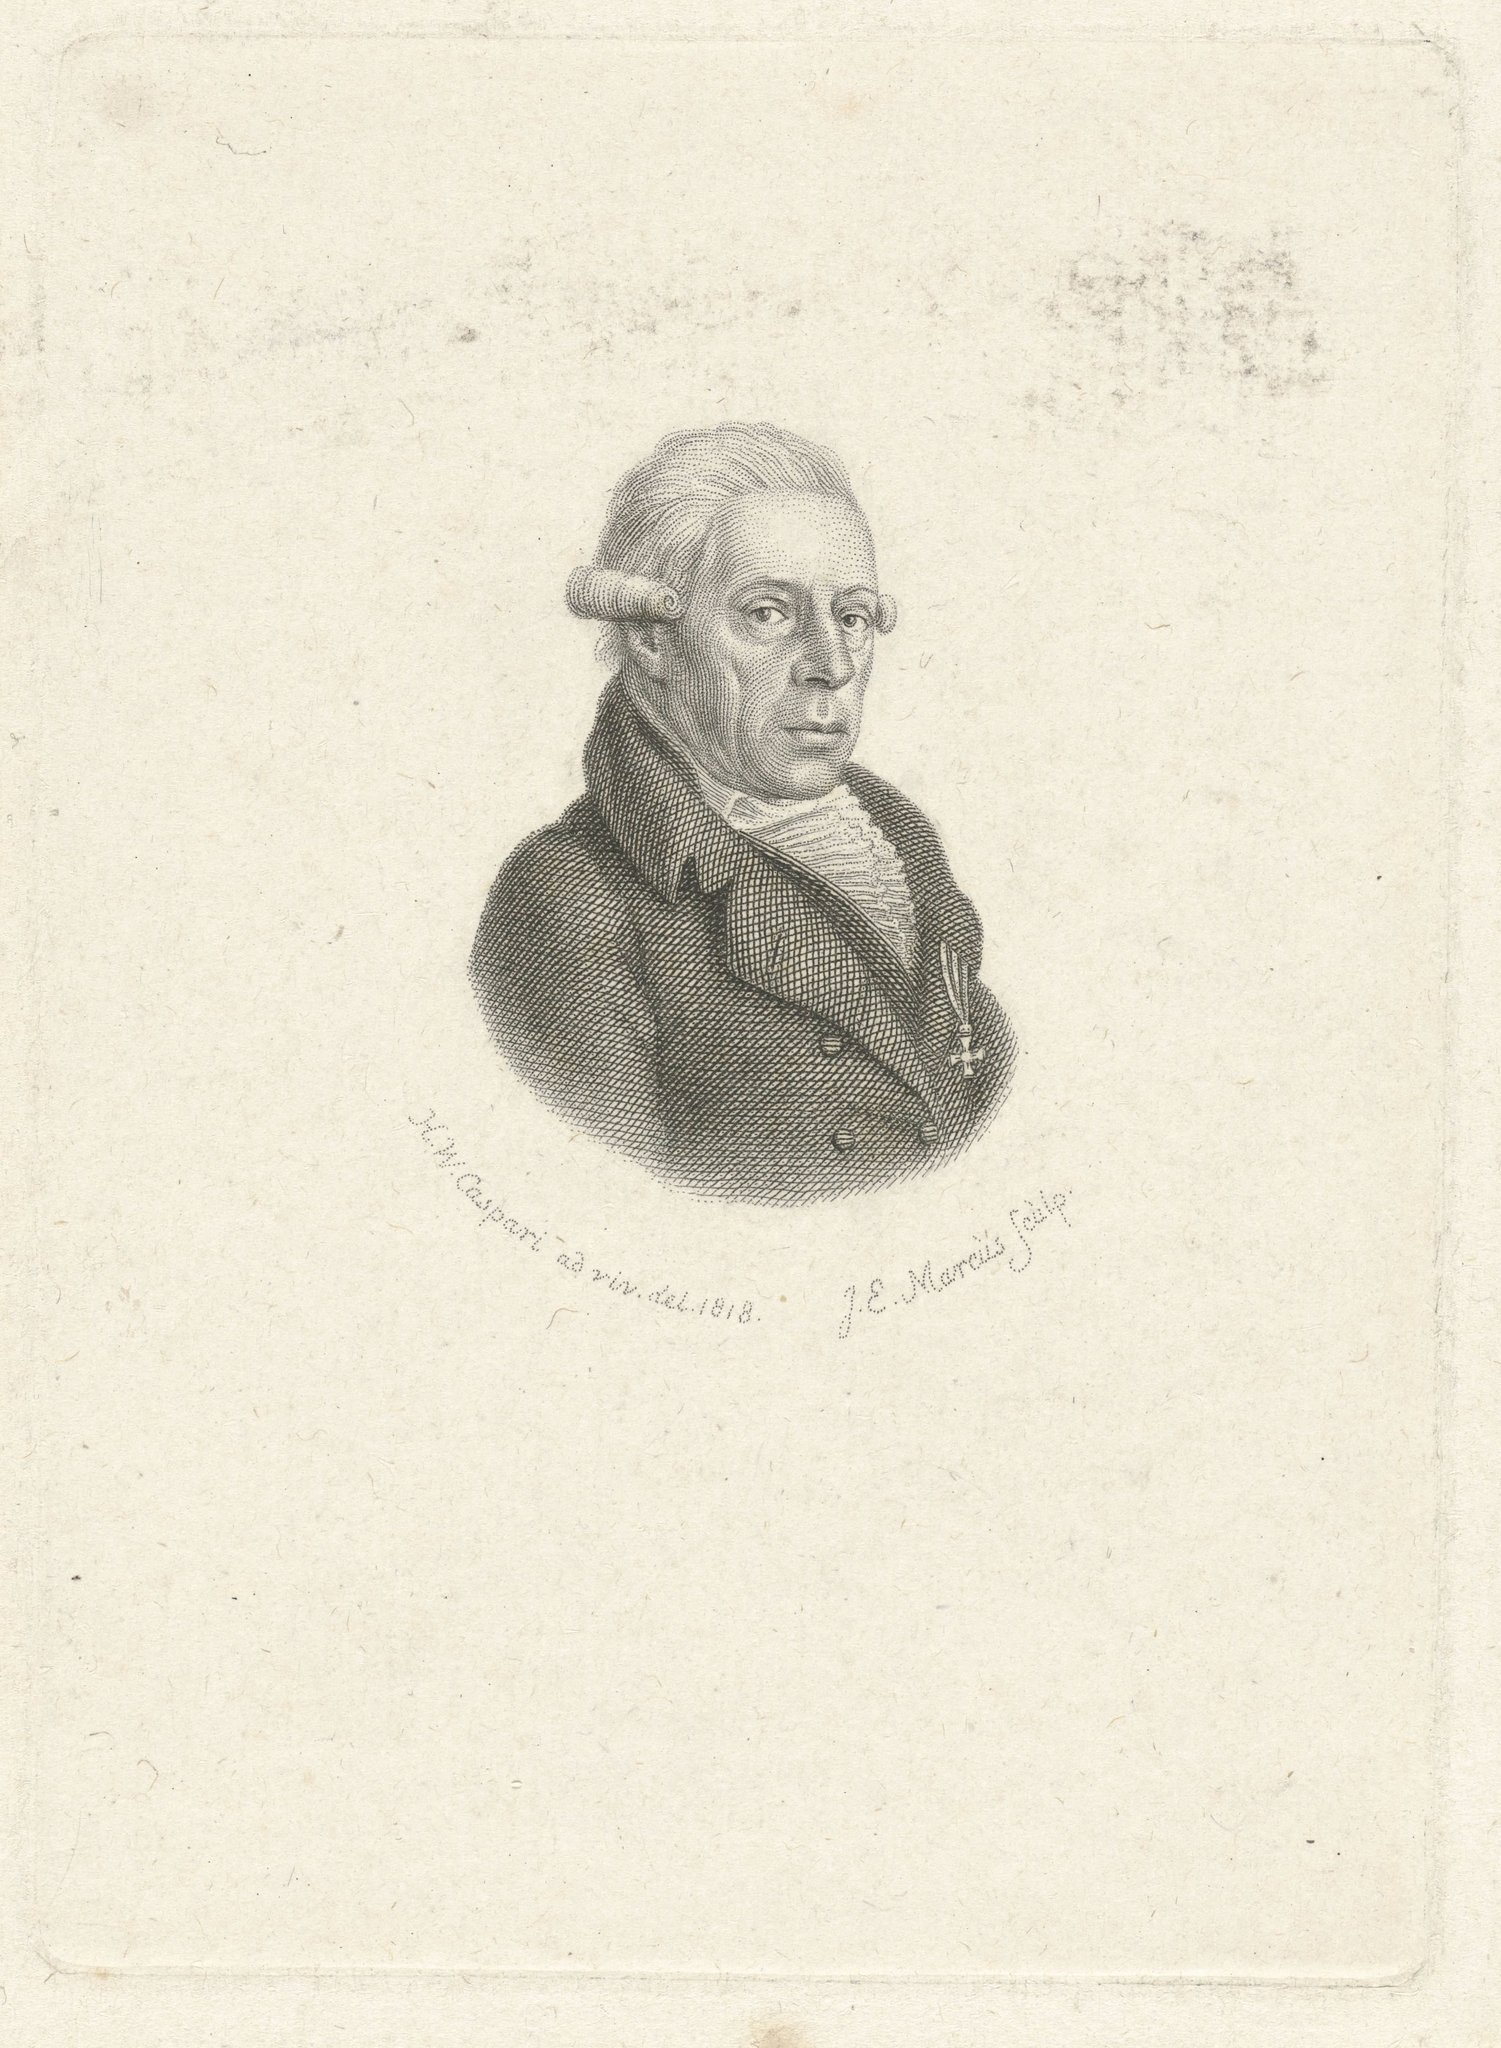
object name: print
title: Portret van Rhijnvis Feith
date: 1818-1826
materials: paper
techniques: etching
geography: amsterdam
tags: rhijnvis feith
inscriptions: collector's mark: Lugt 2228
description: Portret van de dichter en advocaat Rhijnvis Feith.